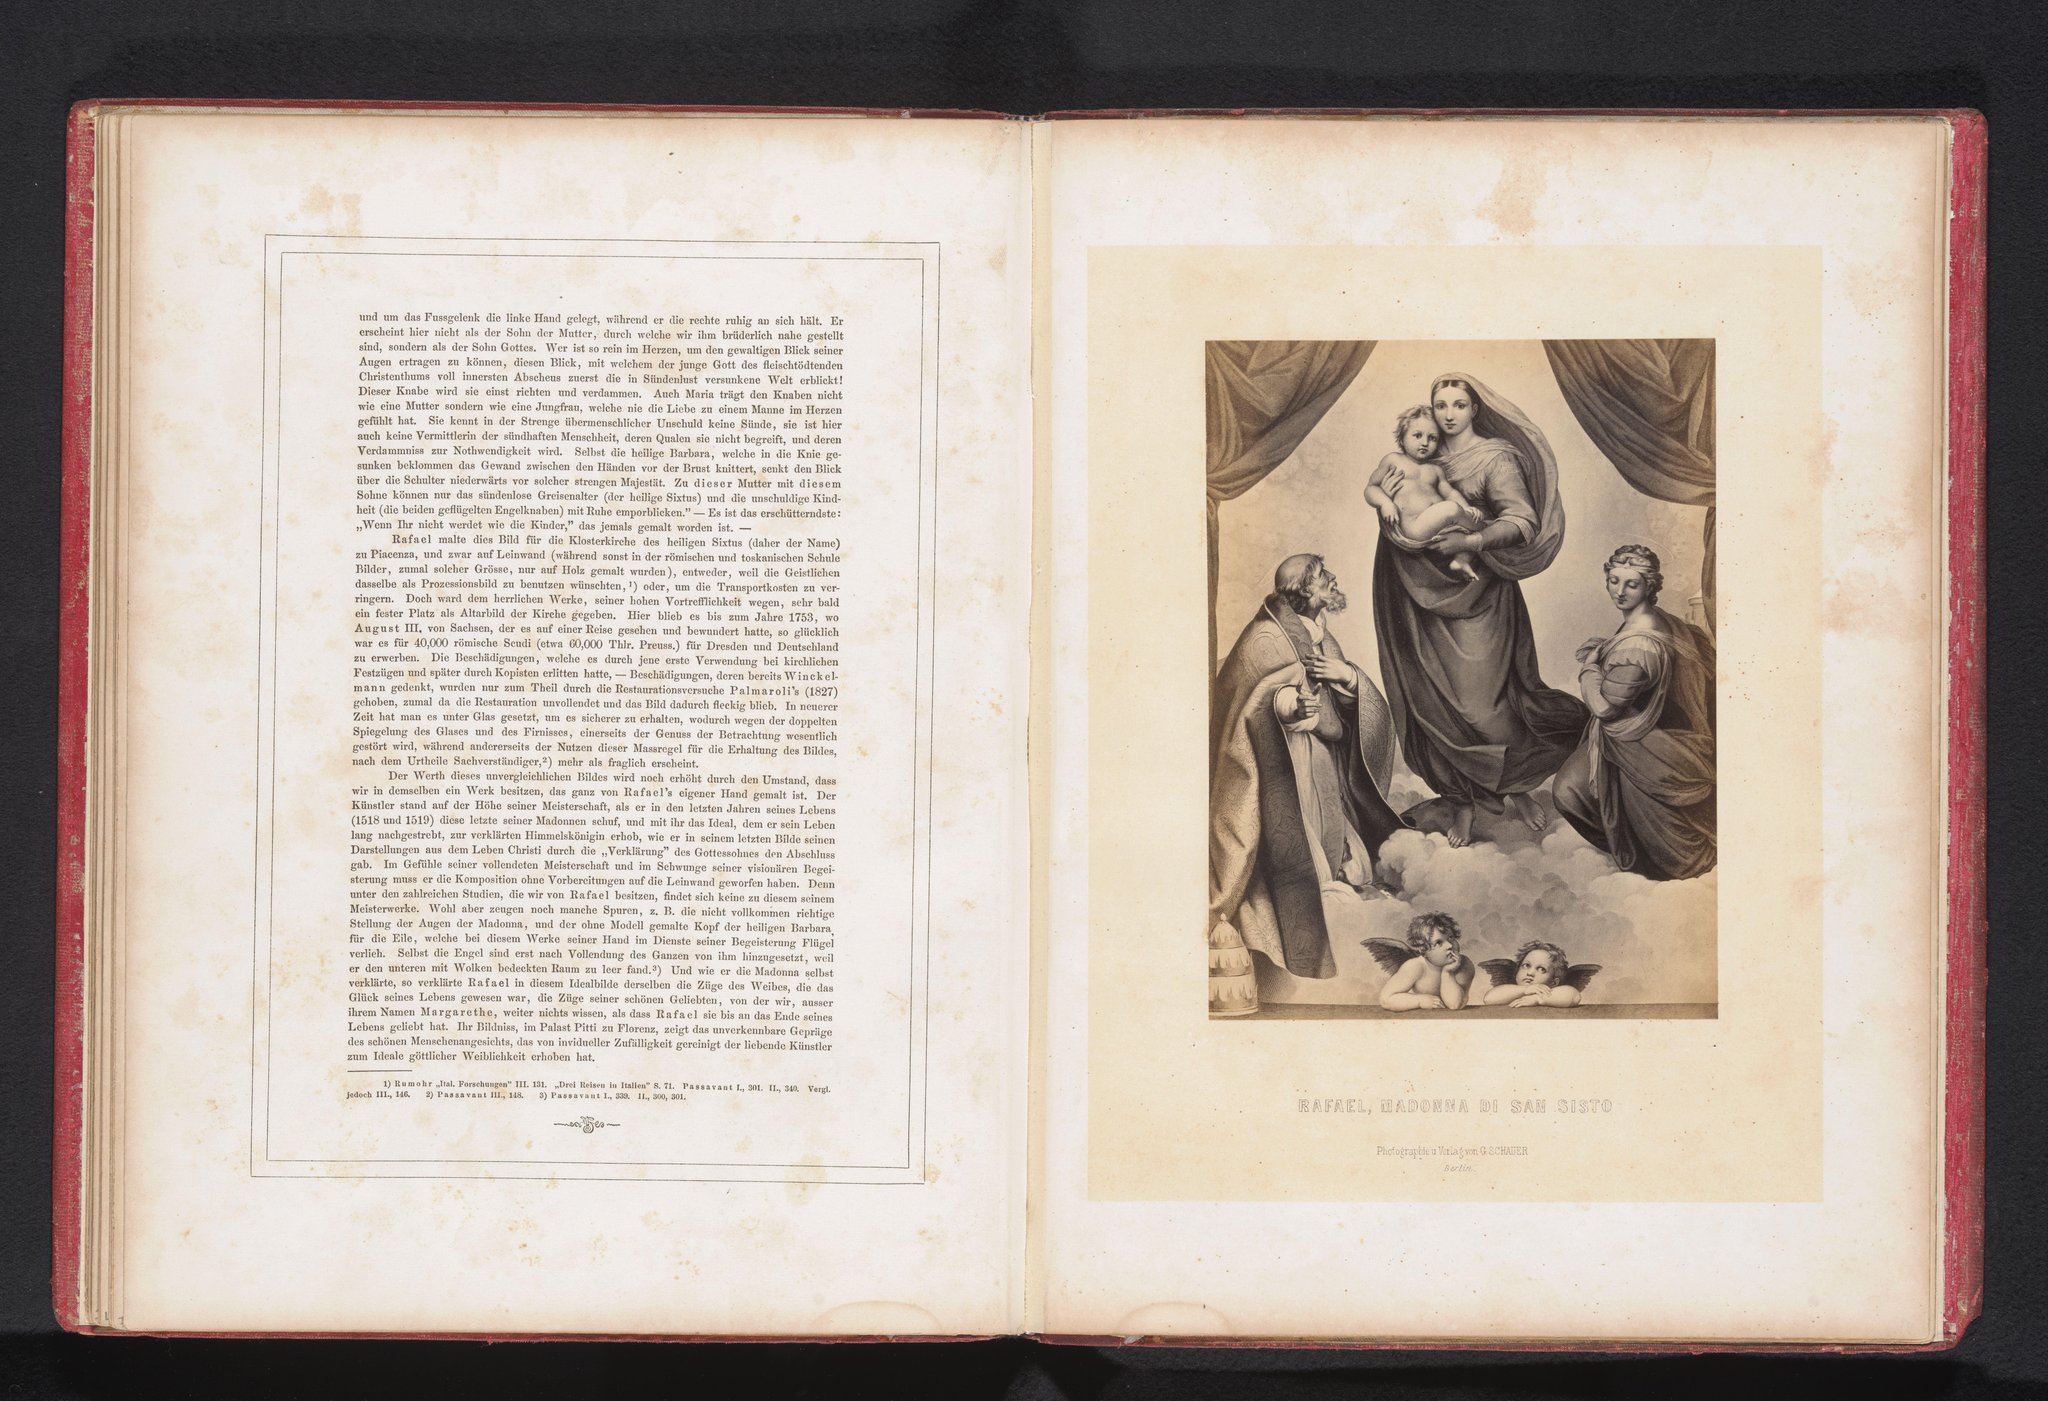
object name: photograph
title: Rafael, Madonna di San Sisto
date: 1851-1861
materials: photographic support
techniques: albumen print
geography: berlin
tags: madonna: i.e. mary with the christ-child